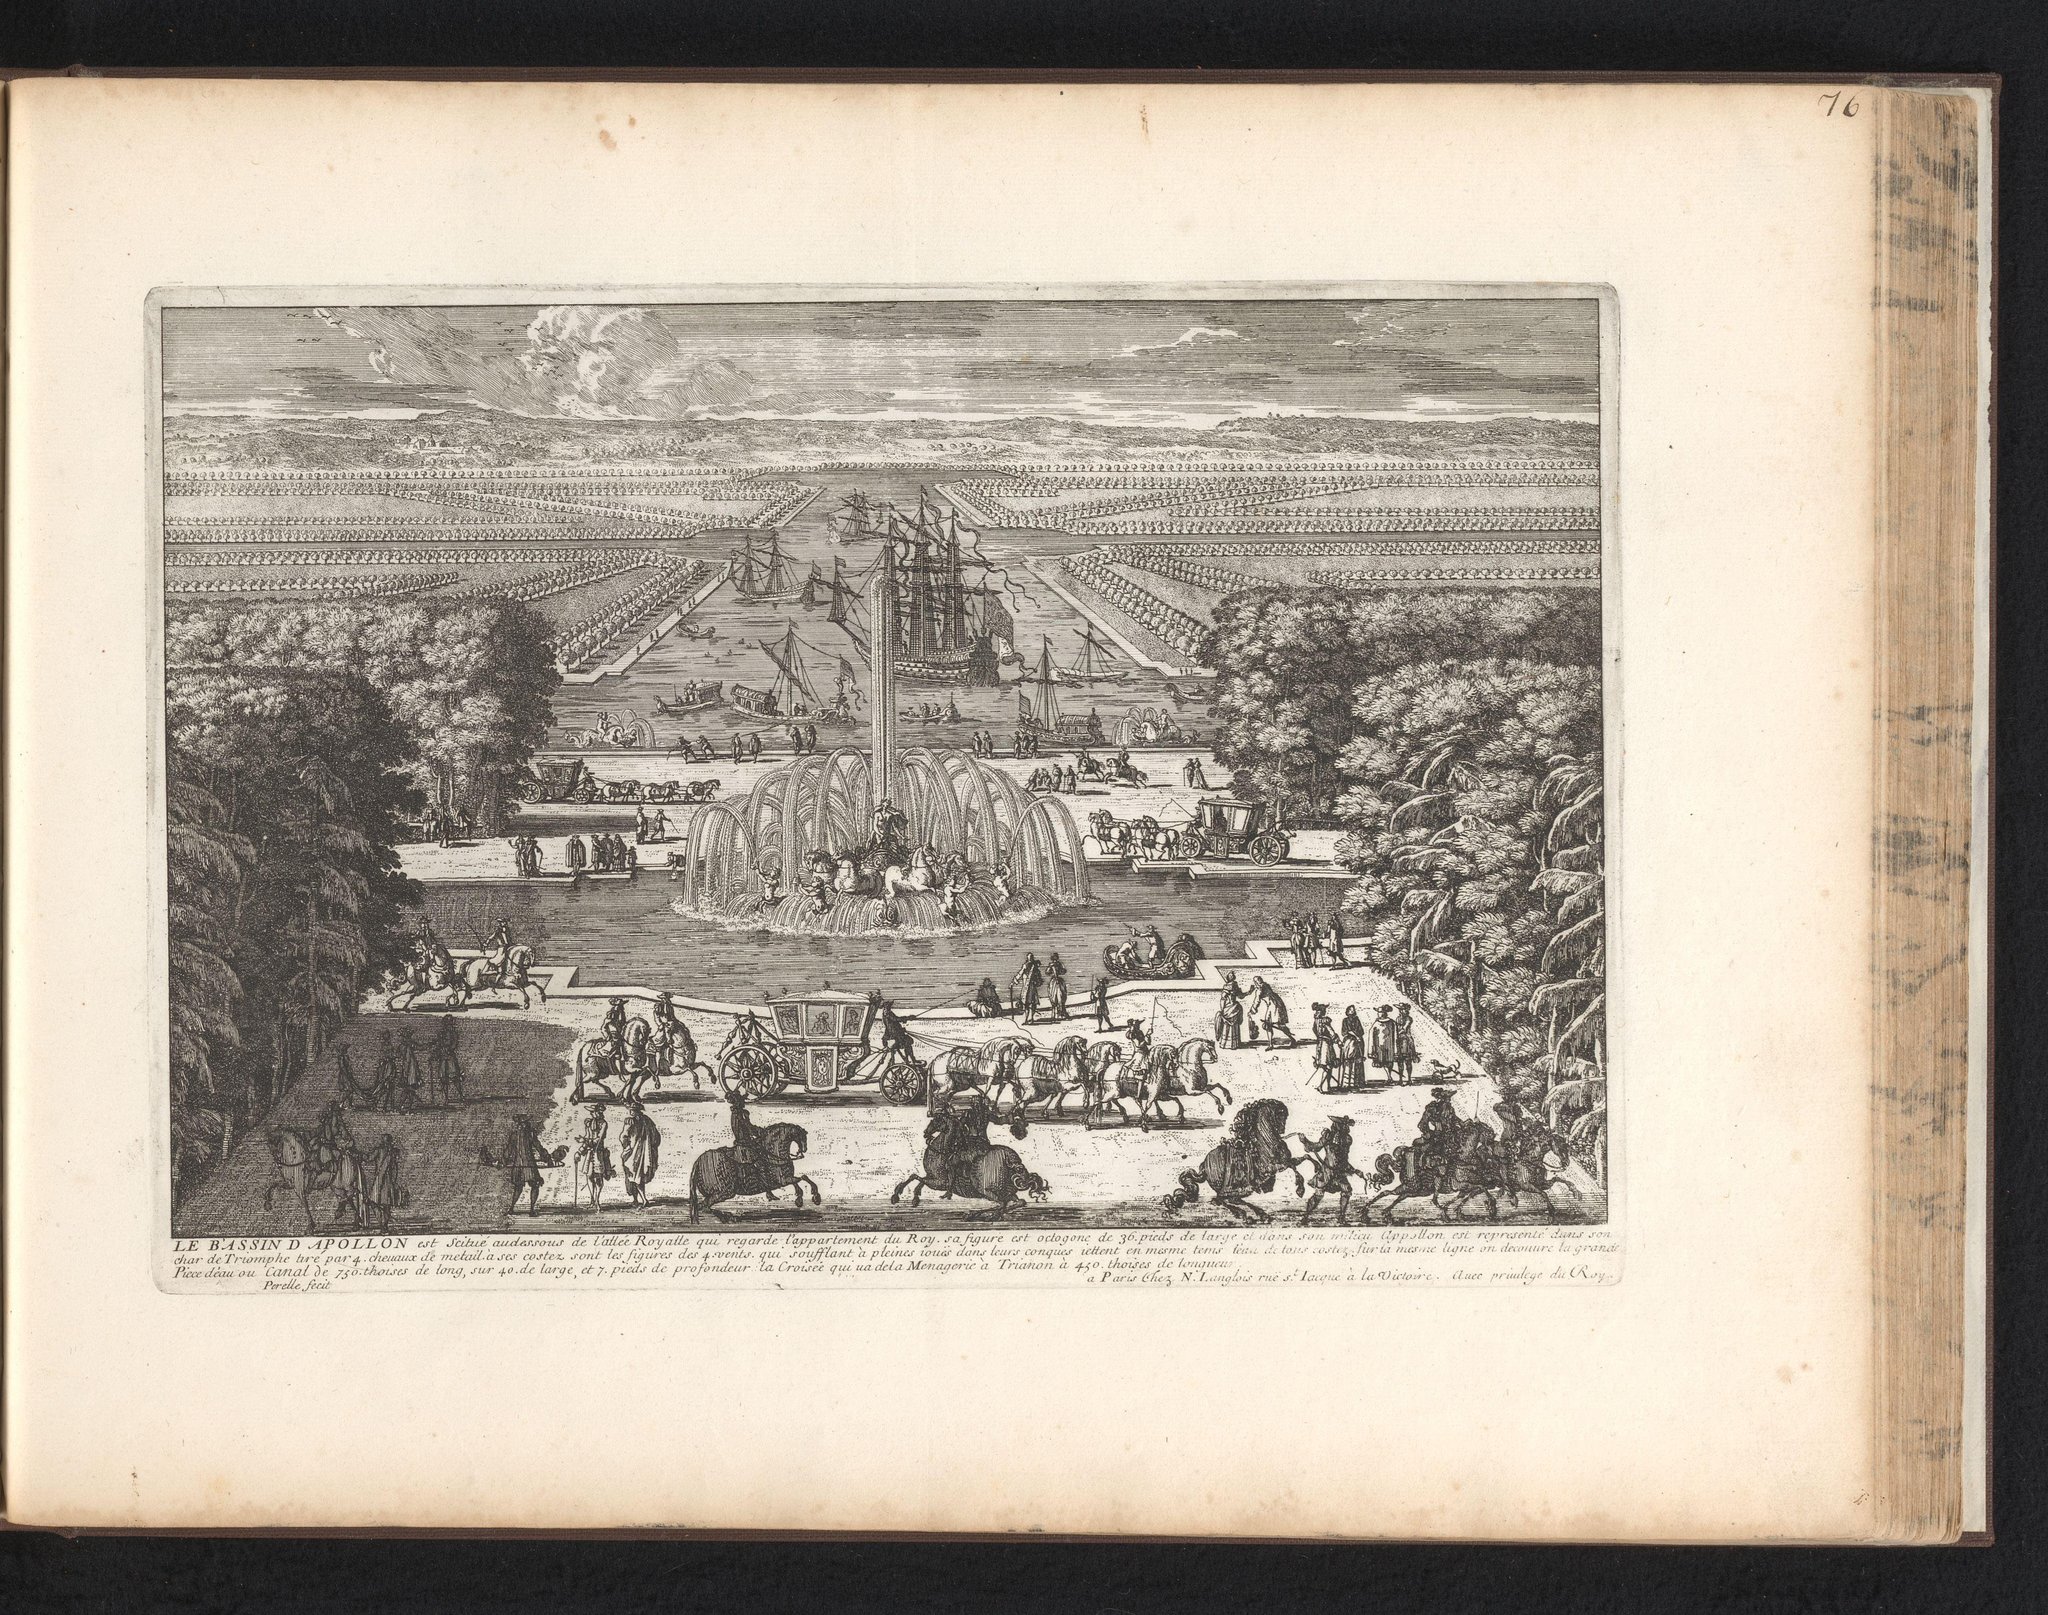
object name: print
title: Gezicht op de fontein van Apollo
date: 1670-1695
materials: paper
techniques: etching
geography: paris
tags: (story of) apollo (phoebus), garden fountain, canal, french or architectonic garden; formal garden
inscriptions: collector's mark: Lugt 2228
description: Prenten met het signatuur 'Perelle' kunnen zowel door vader Gabriel als door zonen Nicolas en Adam gemaakt zijn. De uitgevers vader en zoon Nicolas Langlois worden allebei vermeld als N. Langlois op hetzelfde adres.